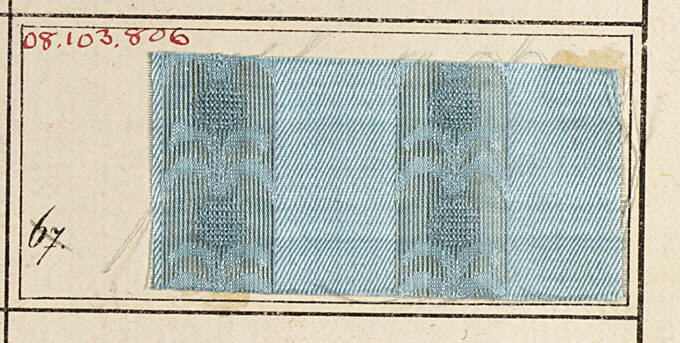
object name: ribbon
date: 1701-1900